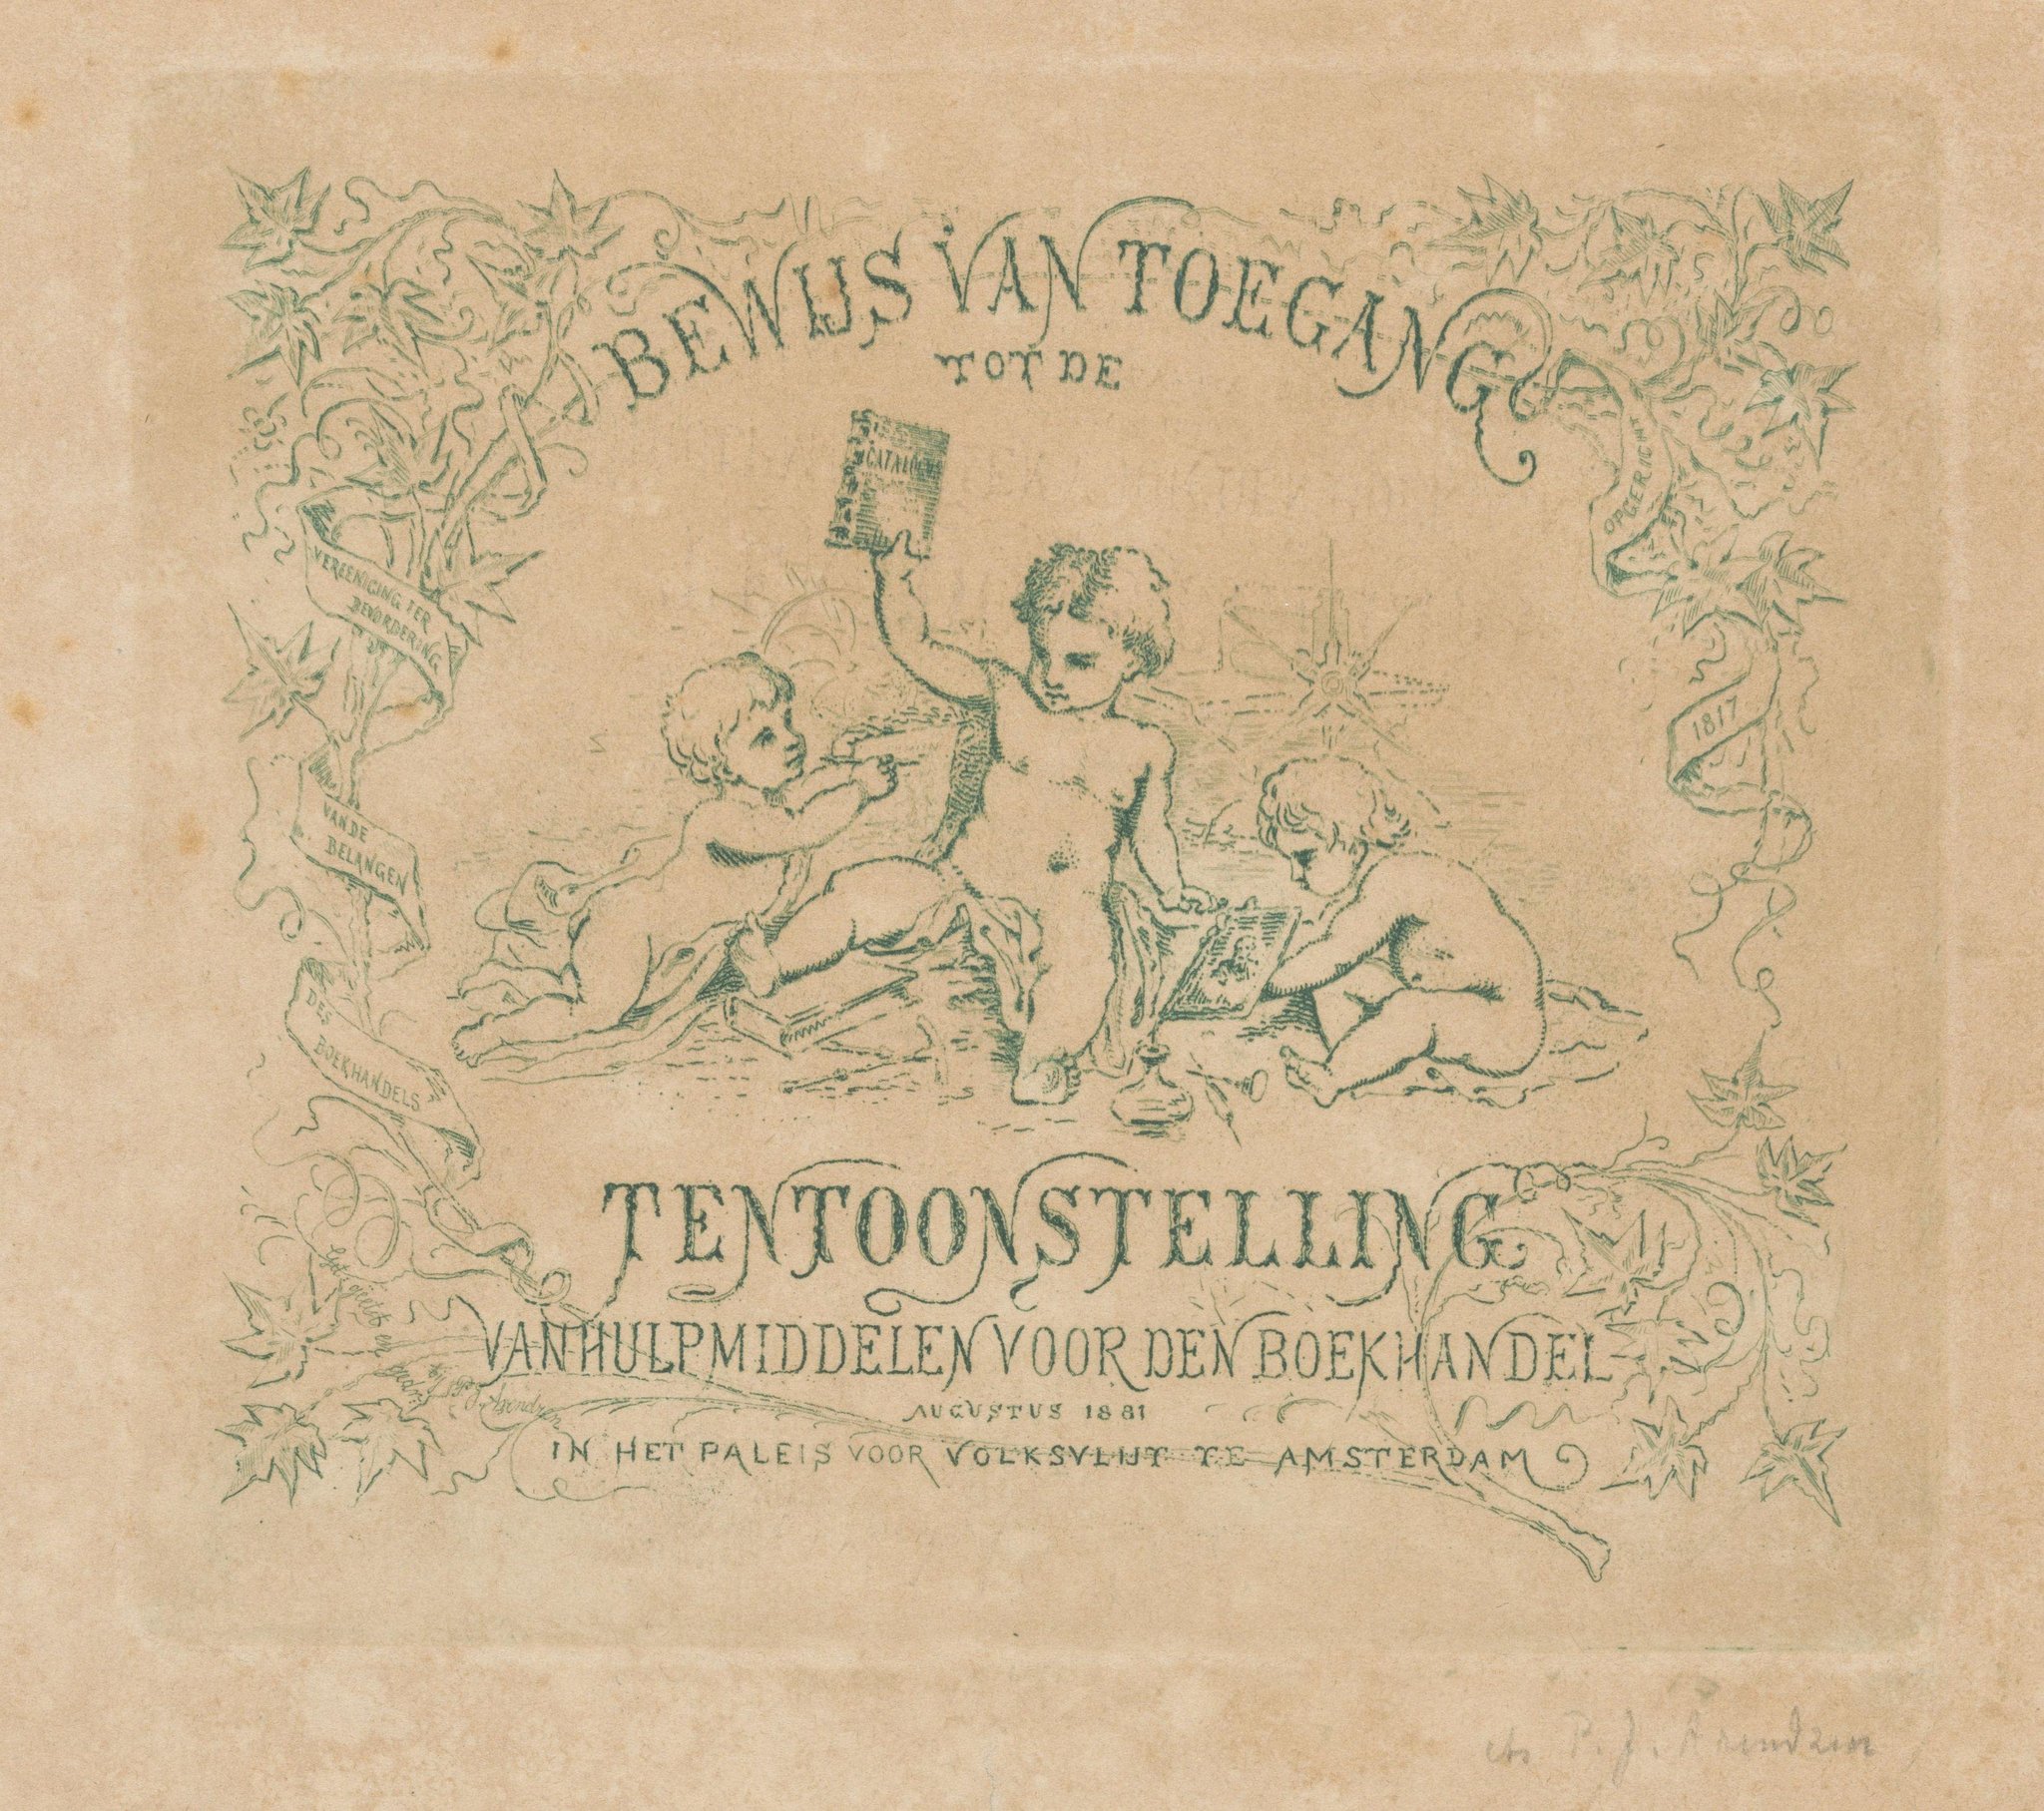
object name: print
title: Toegangsbewijs voor de tentoonstelling van hulpmiddelen voor den boekhandel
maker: petrus johannes arendzen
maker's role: draughtsman, print maker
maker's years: 1846-1932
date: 1808-1881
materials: paper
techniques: etching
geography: amsterdam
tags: foliage, tendrils, branches ~ ornament - aa - stylized, printing press, tools, implements of graphic artist, cupids: 'amores', 'amoretti', 'putti'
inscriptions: collector's mark: Lugt 2228, collector's mark: Lugt 4779, collector's mark: Lugt 4780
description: De middelste putto houdt een catalogus omhoog, de linker tekent op een lithosteen en de rechter giet etswater van een koperplaat terug in de fles. In de achtergrond staat een drukpers.